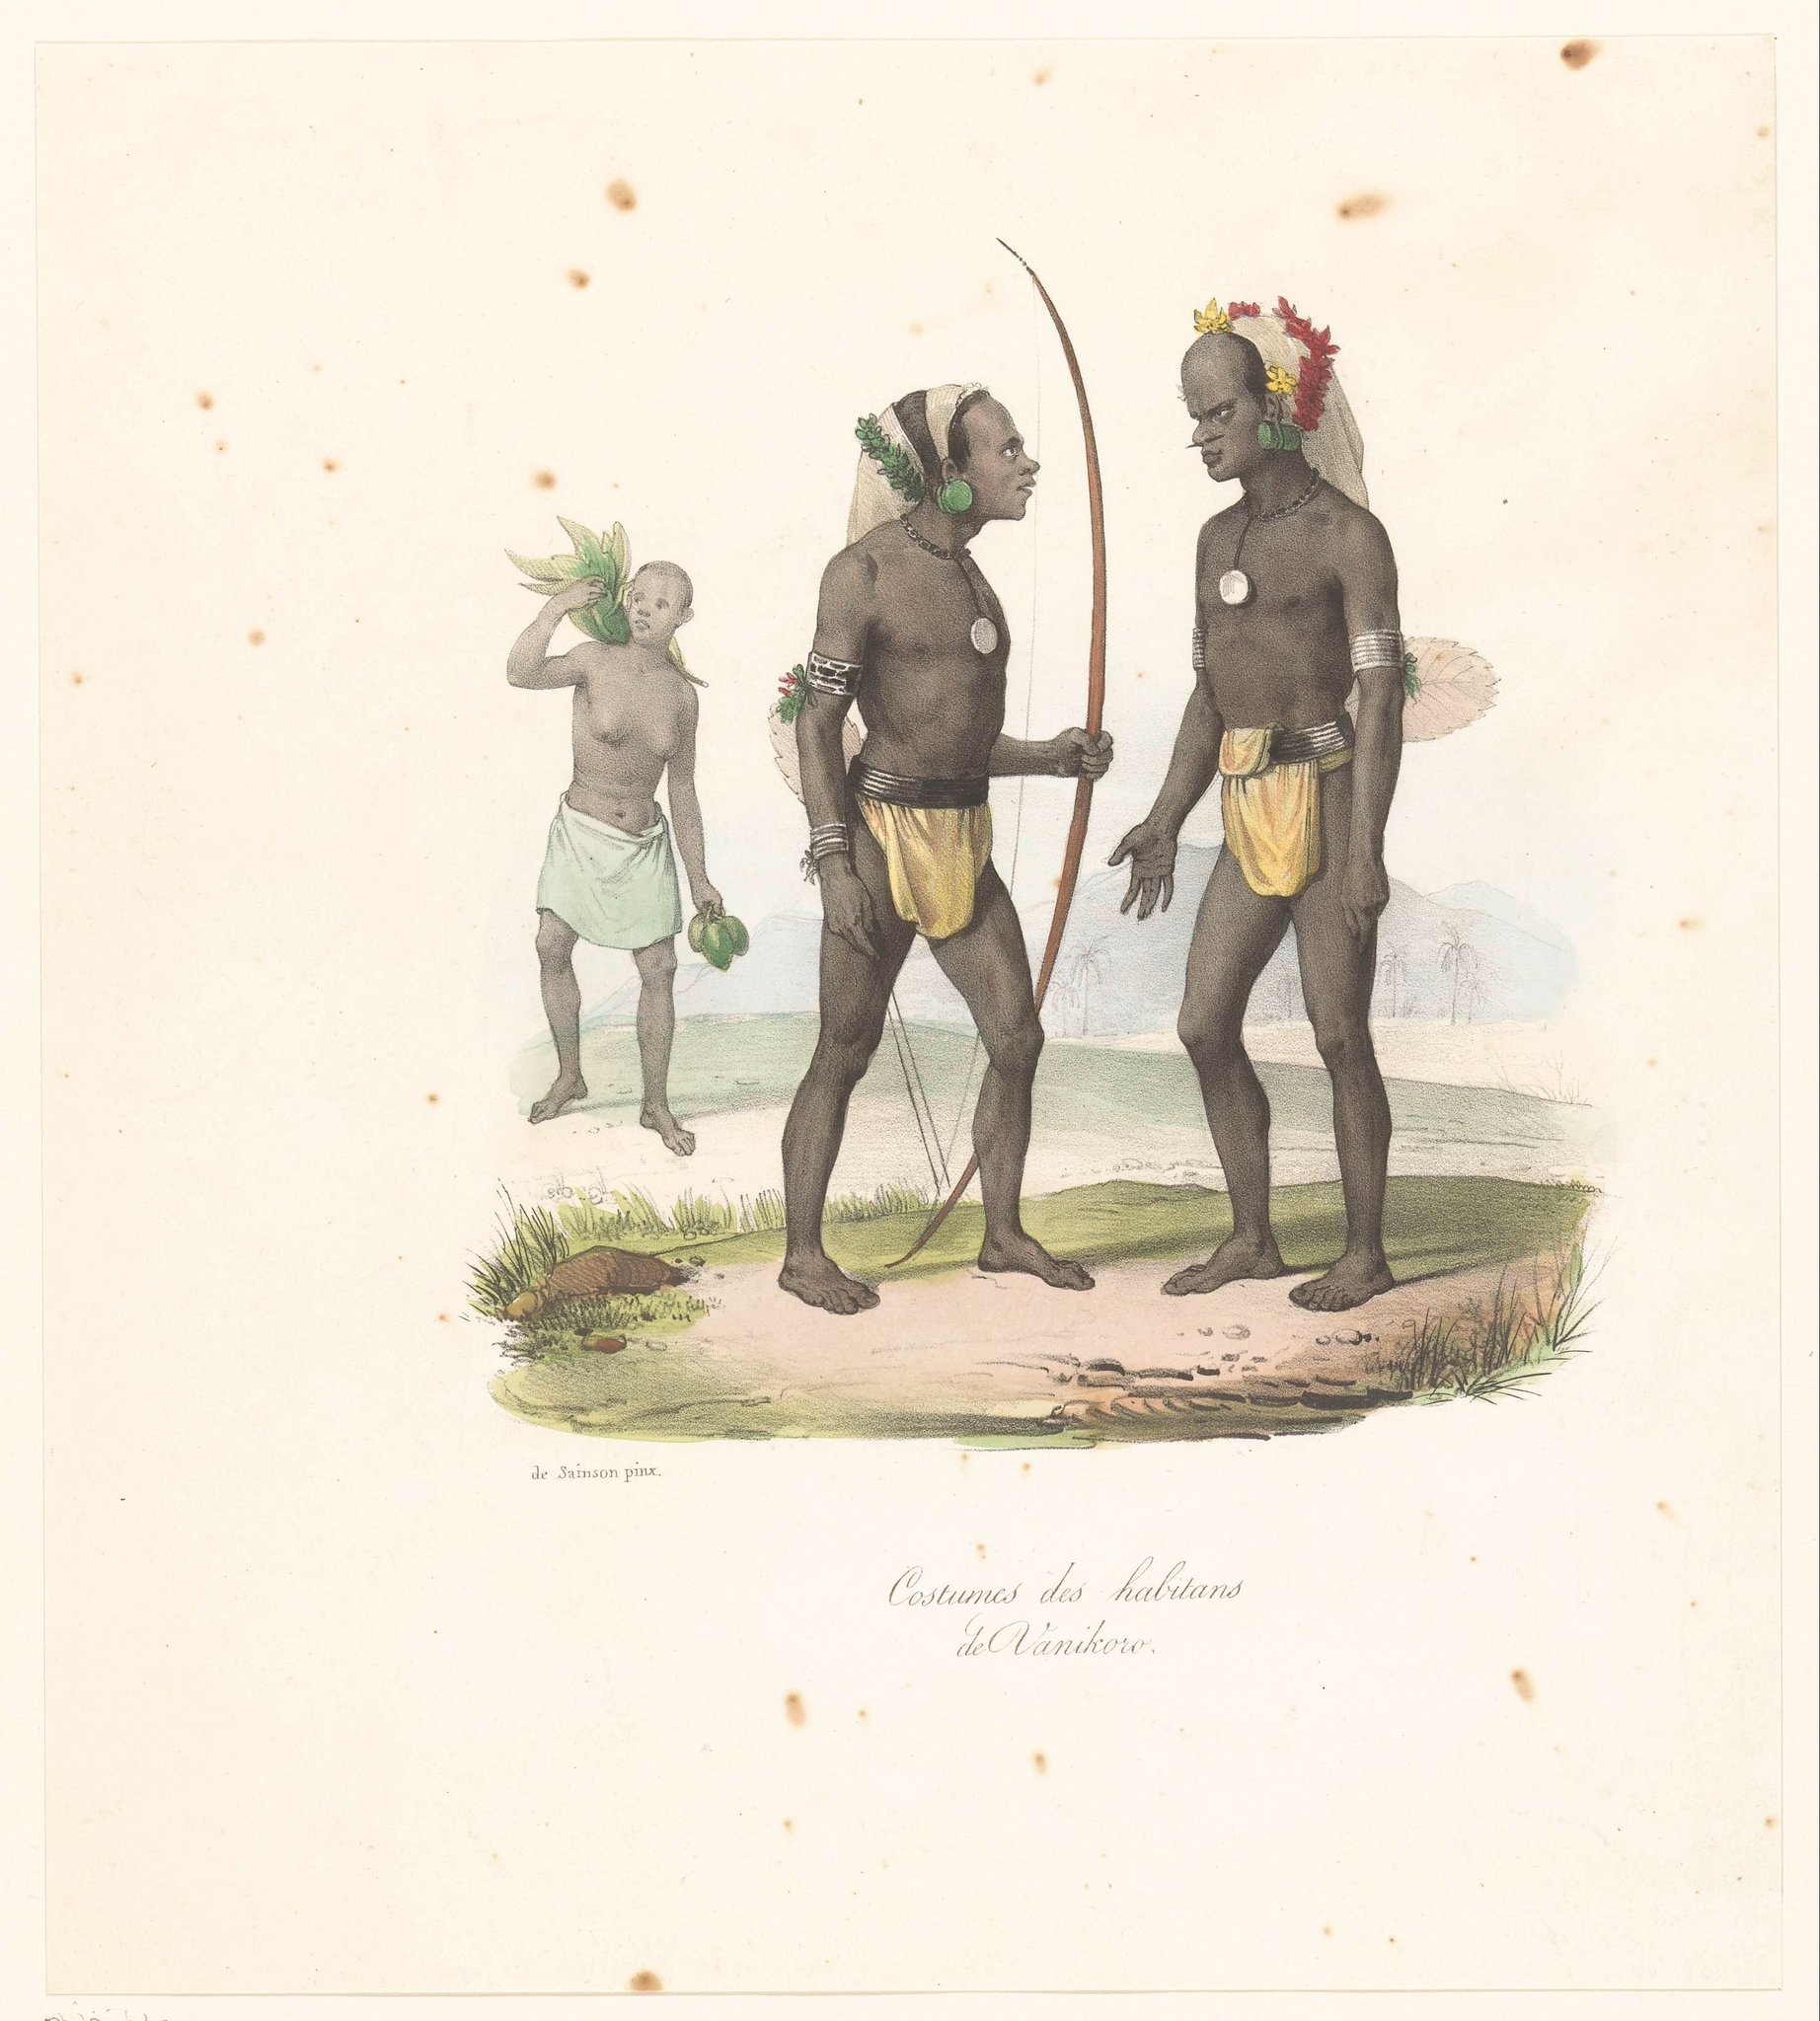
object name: print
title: Costumes des habitans de Vanikoro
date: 1830-1835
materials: paper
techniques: hand coloring, lithograph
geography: paris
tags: folk costume, regional costume, australian and oceanian races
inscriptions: collector's mark: Lugt 2228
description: In 1830-1833 werd de publicatie 'Voyage de la corvette l'Astrolabe exécuté par ordre du roi, pendant les années 1826-1827-1828-1829 (...)' in zeventien delen uitgegeven door J. Tastu in Parijs. De auteur van dit verslag van een Franse expeditie met het schip 'l'Astrolabe' was J. Dumont d'Urville. De publicatie was verrijkt met illustraties van verschillende lithografen, naar ontwerp van Louis-Auguste de Sainson, die zelf had deelgenomen aan de expeditie.